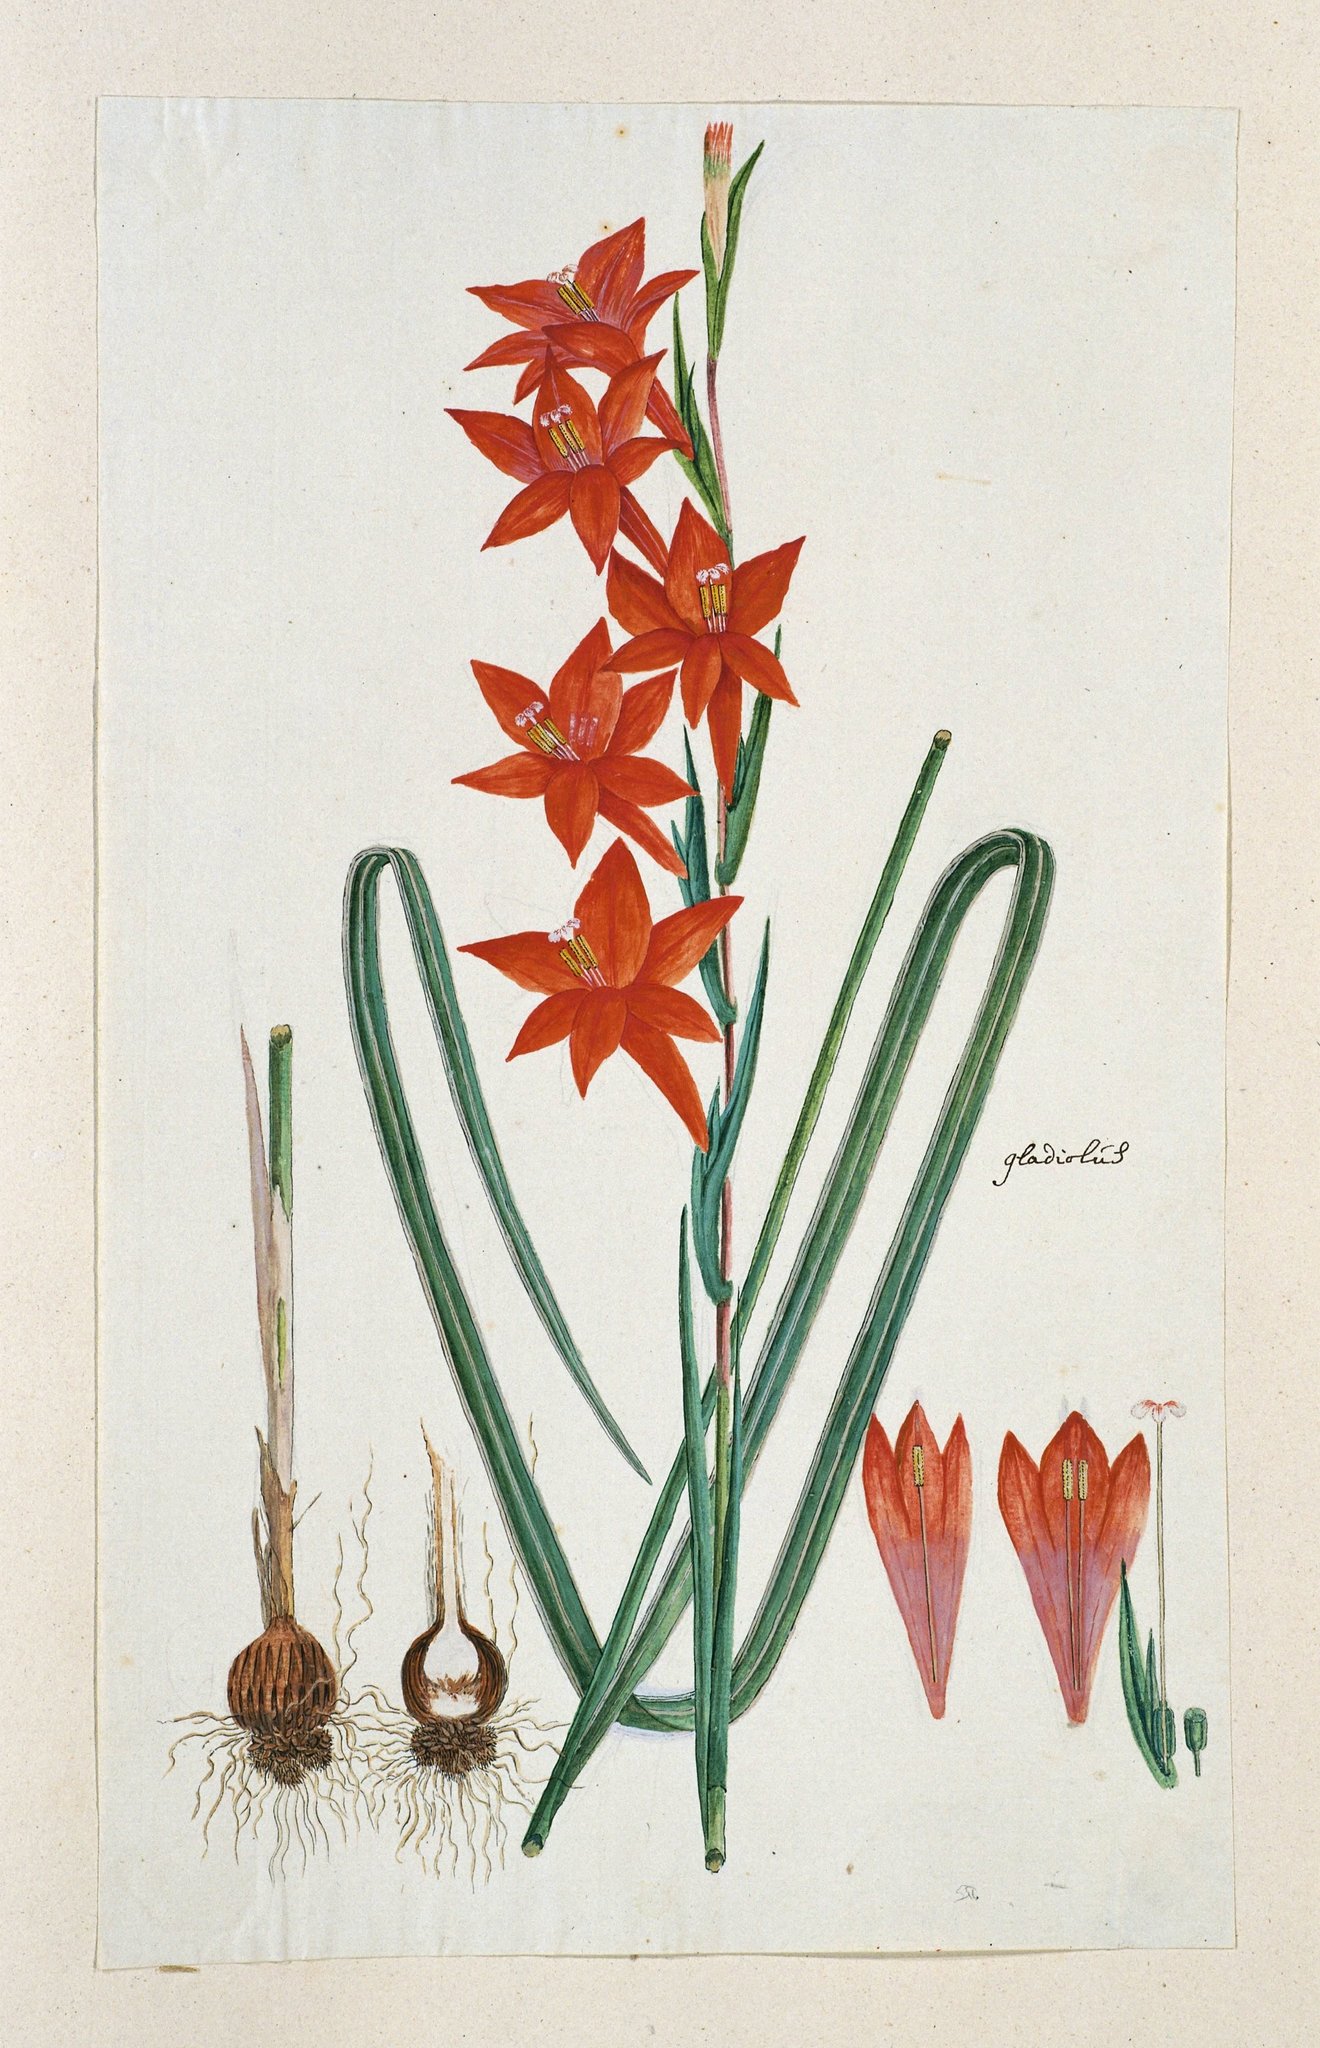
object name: album leaf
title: Gladiolus watsonius Thunb. (Watsonia hysterantha)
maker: robert jacob gordon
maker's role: draughtsman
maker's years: 1743-1795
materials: chalk, paint, ink, paper, pencil, watercolor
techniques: brush, pen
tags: plants; vegetation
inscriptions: annotation: ‘gladiolús’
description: De tekening is gemaakt voor of tijdens een van Gordon's vier expedities door de Kaapprovincie, van oktober 1777 tot maart 1786. Sommige (soort)namen kunnen zijn gewijzigd, gezien reorganisatie in plantentaxonomie gedurende de afgelopen jaren.